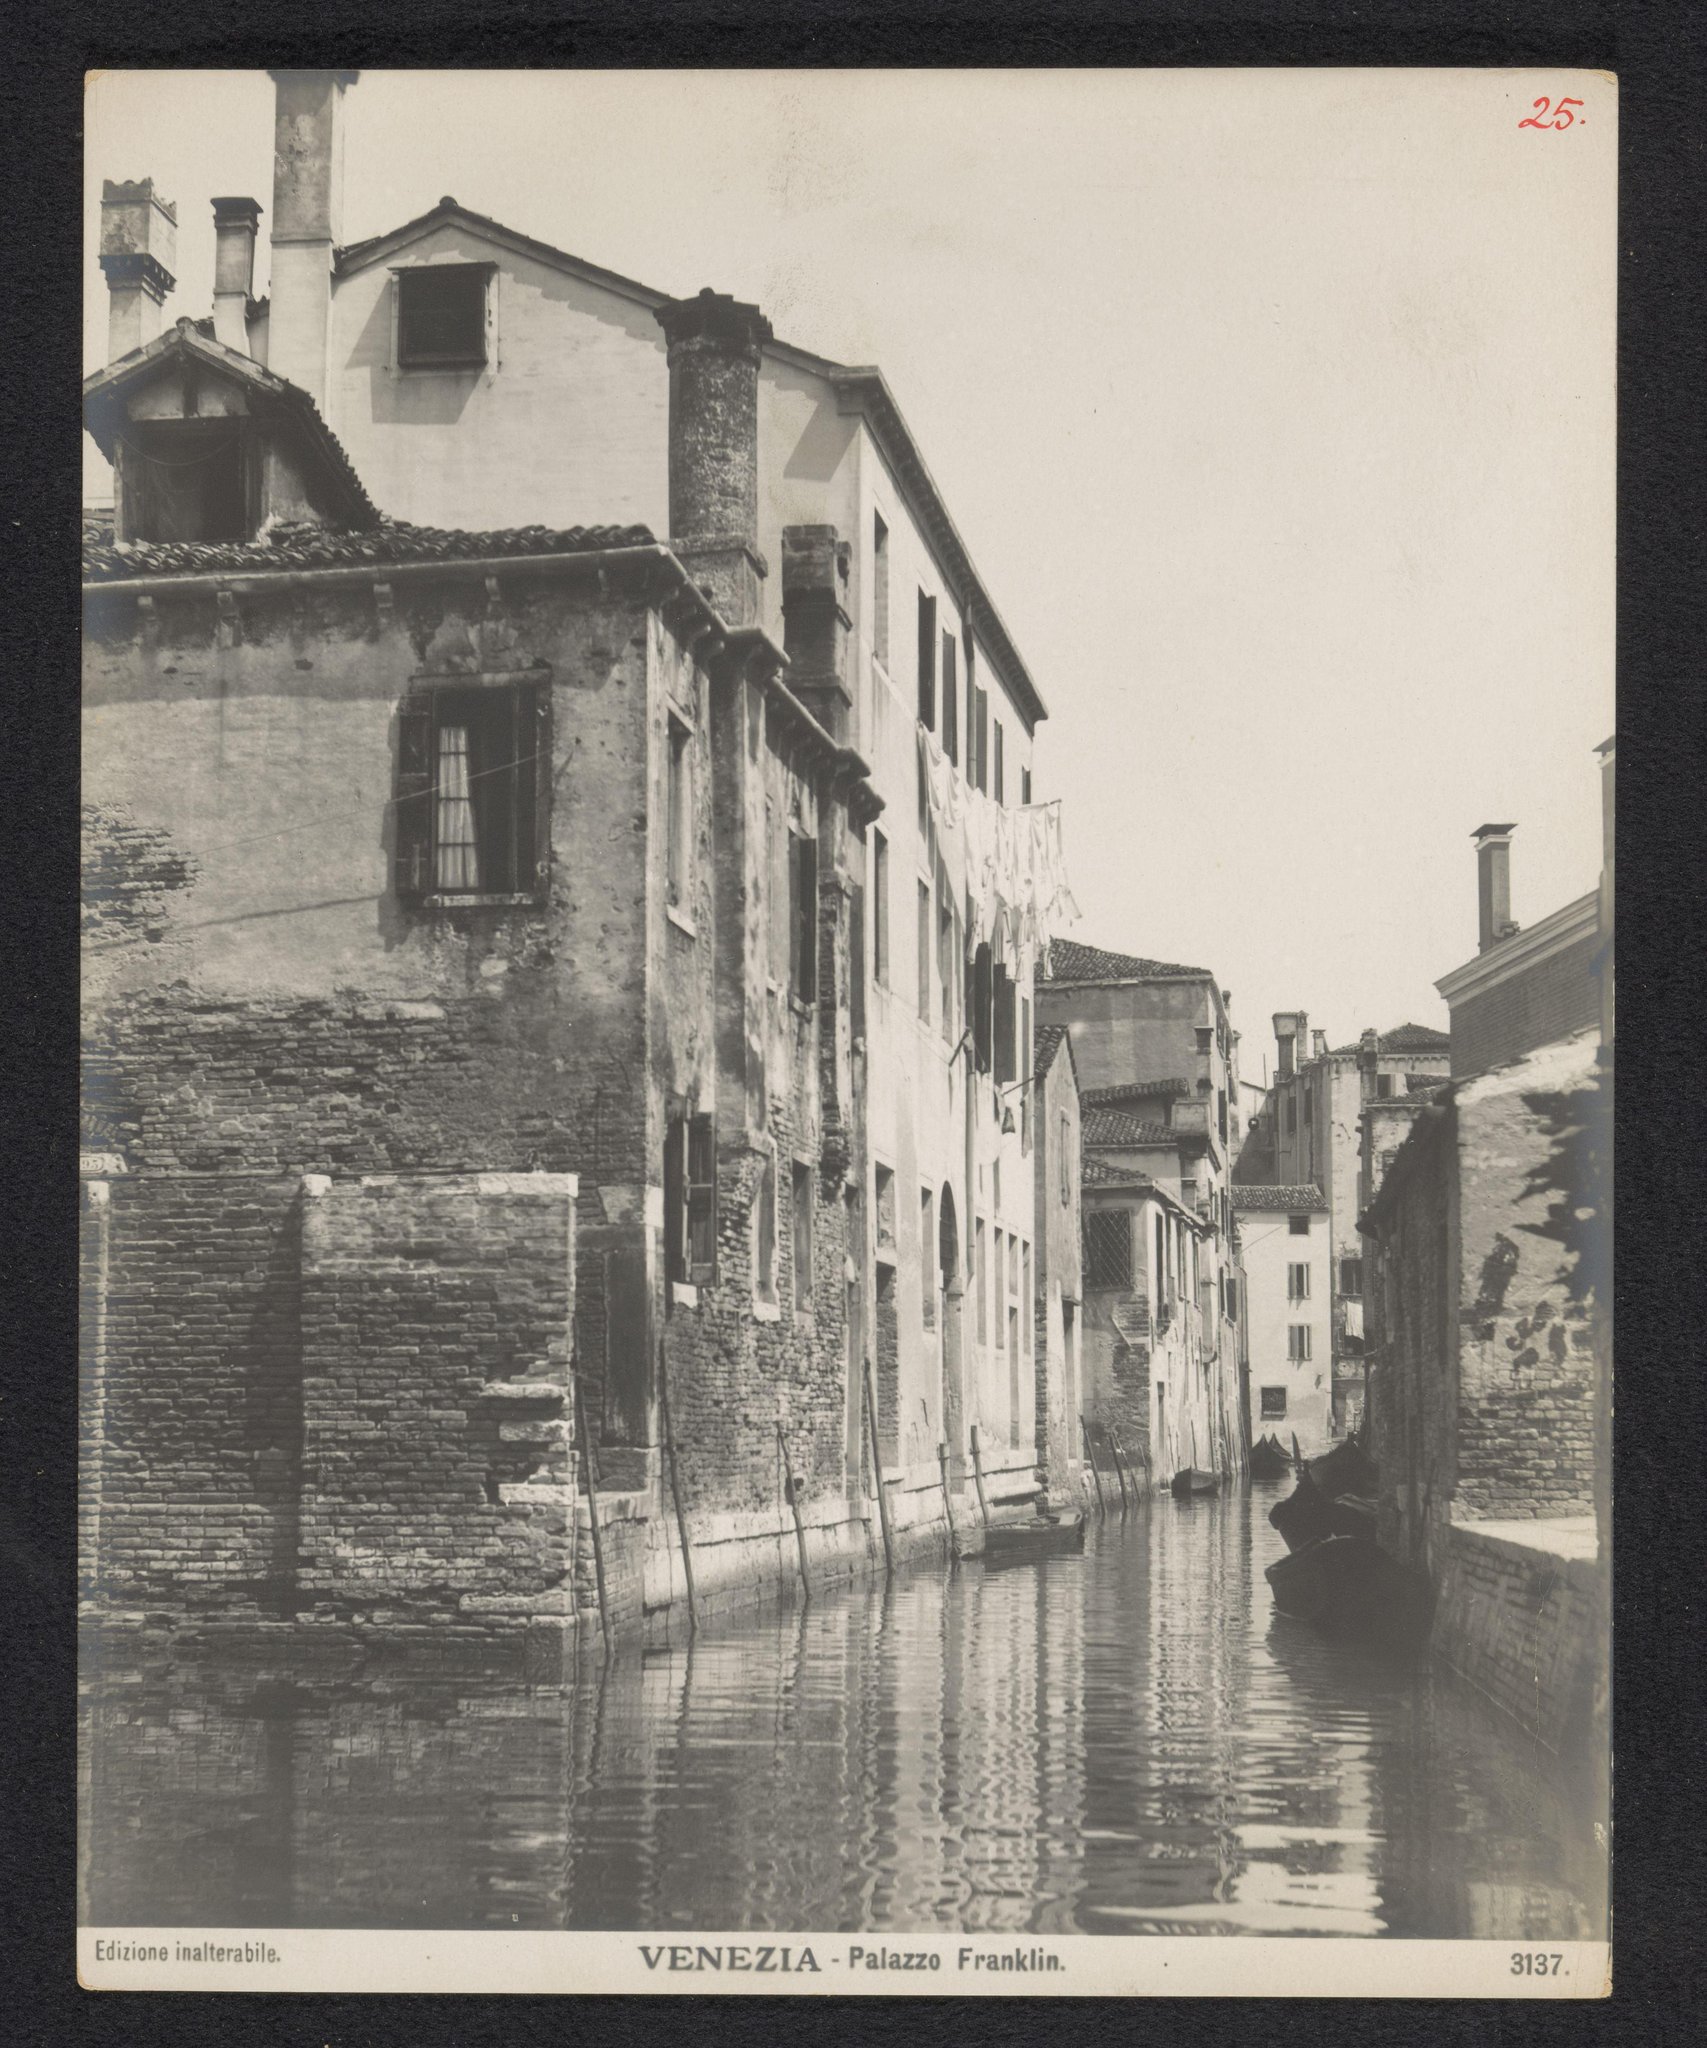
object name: photograph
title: Venezia - Palazzo Franklin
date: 1900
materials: cardboard, photographic support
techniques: gelatin silver print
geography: venice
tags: canal, façade (of house or building), gondola, venice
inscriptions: number: ‘3137.’, inscription: ‘Rijksnormaalschool voor Teekenonderwijzers Amsterdam’, number: ‘25.’